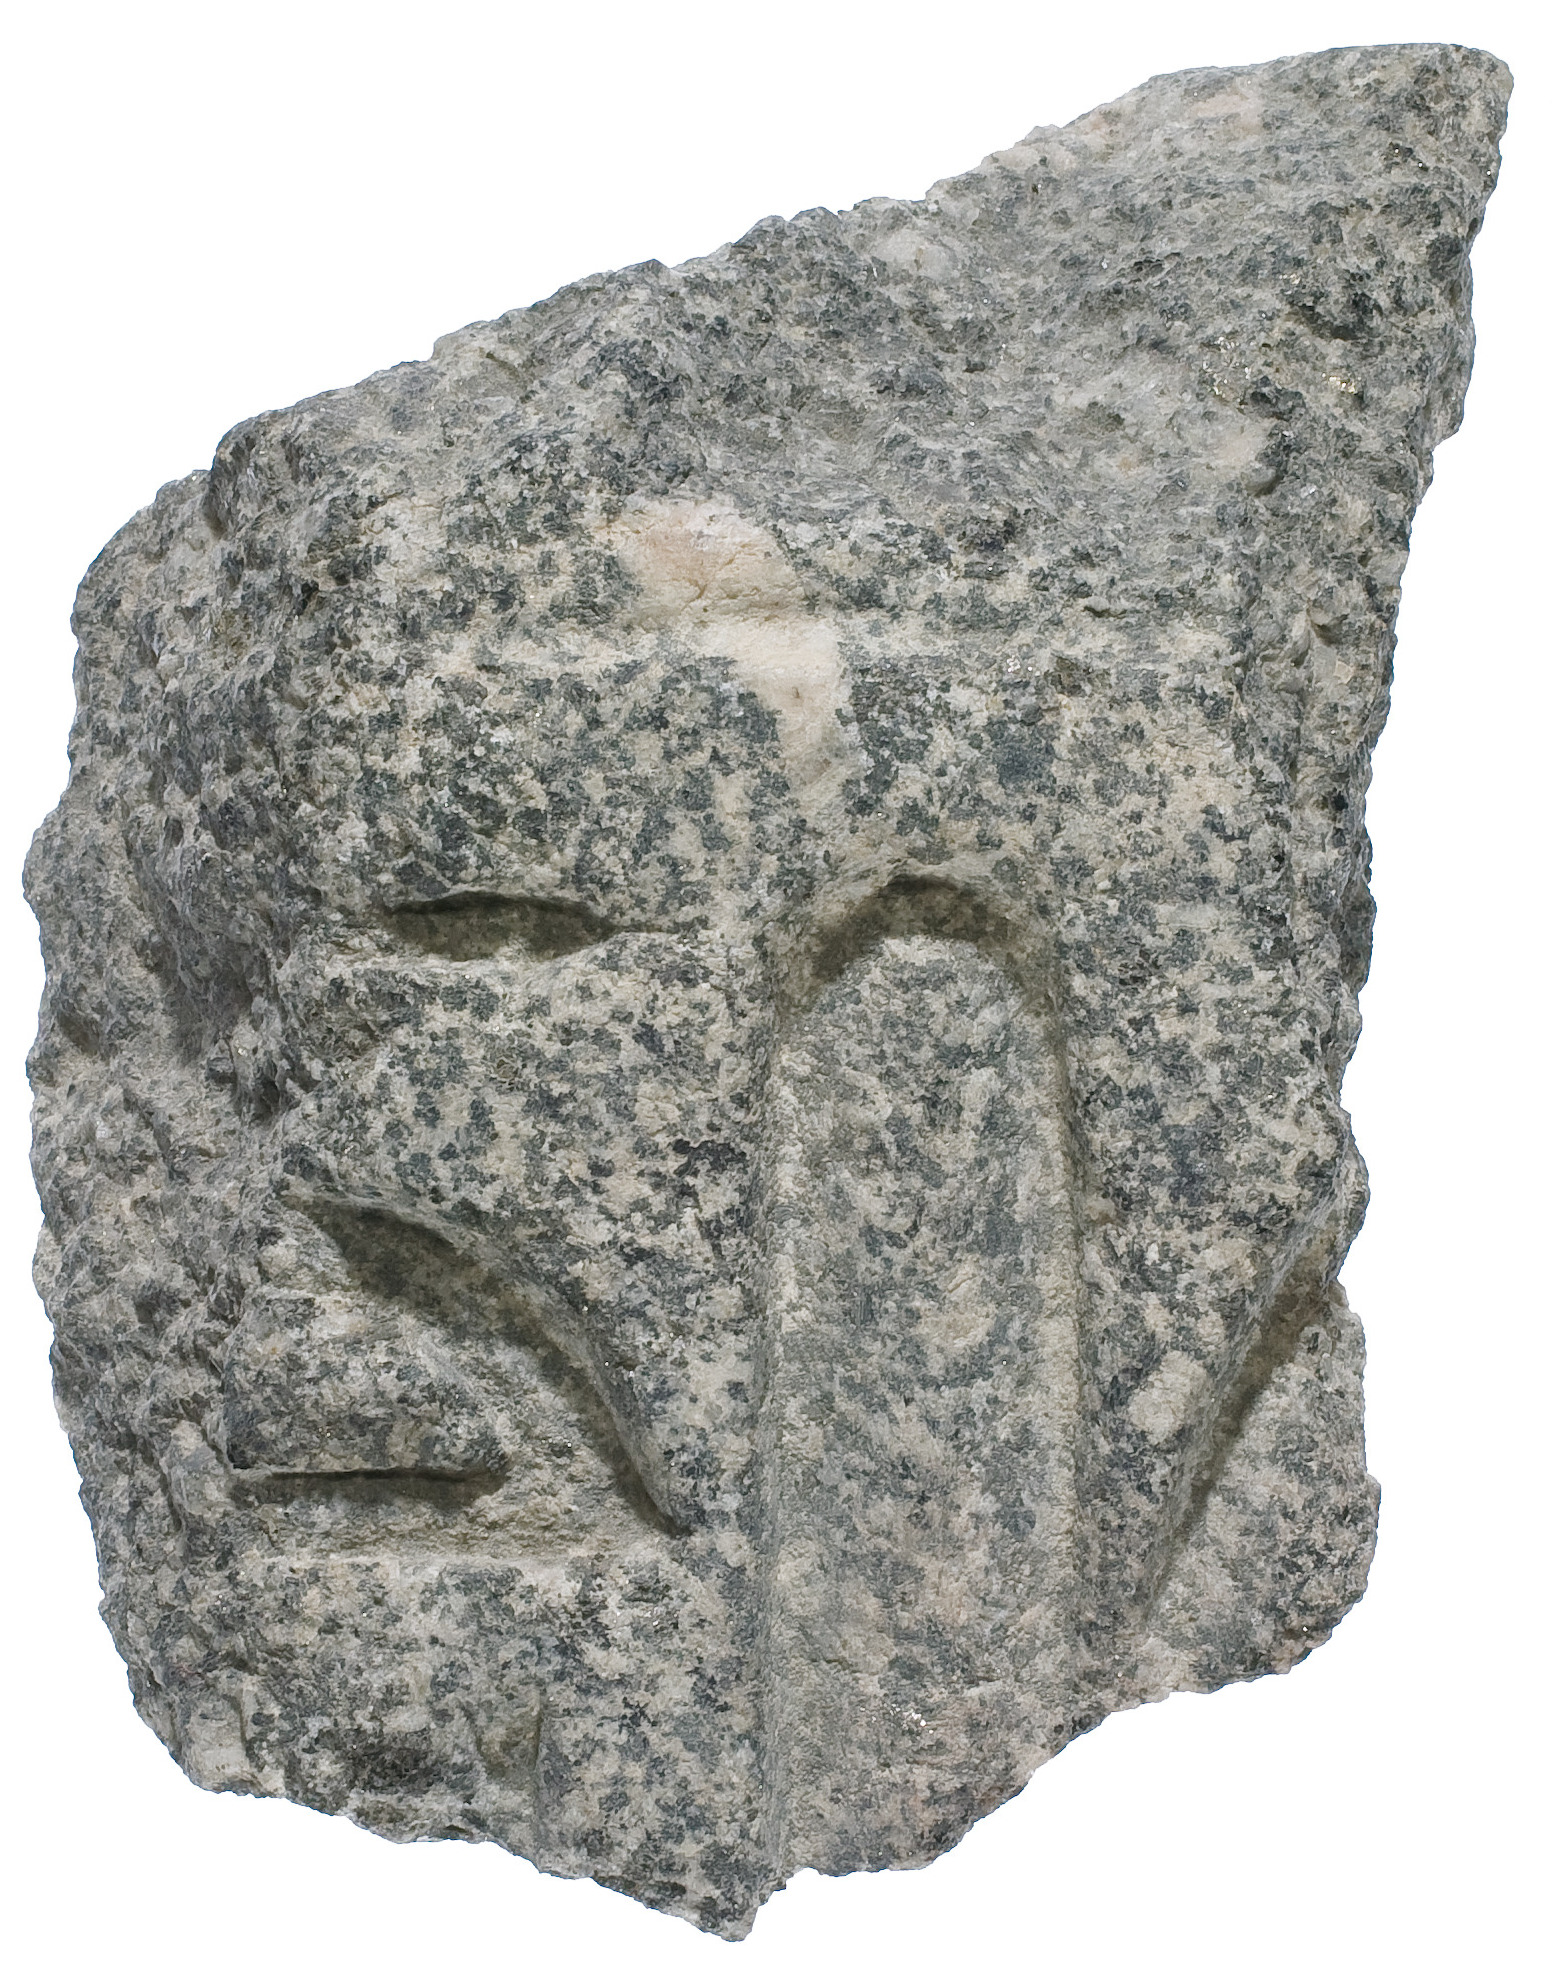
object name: cartouche of akhenaten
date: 1353-1336 BCE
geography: egypt